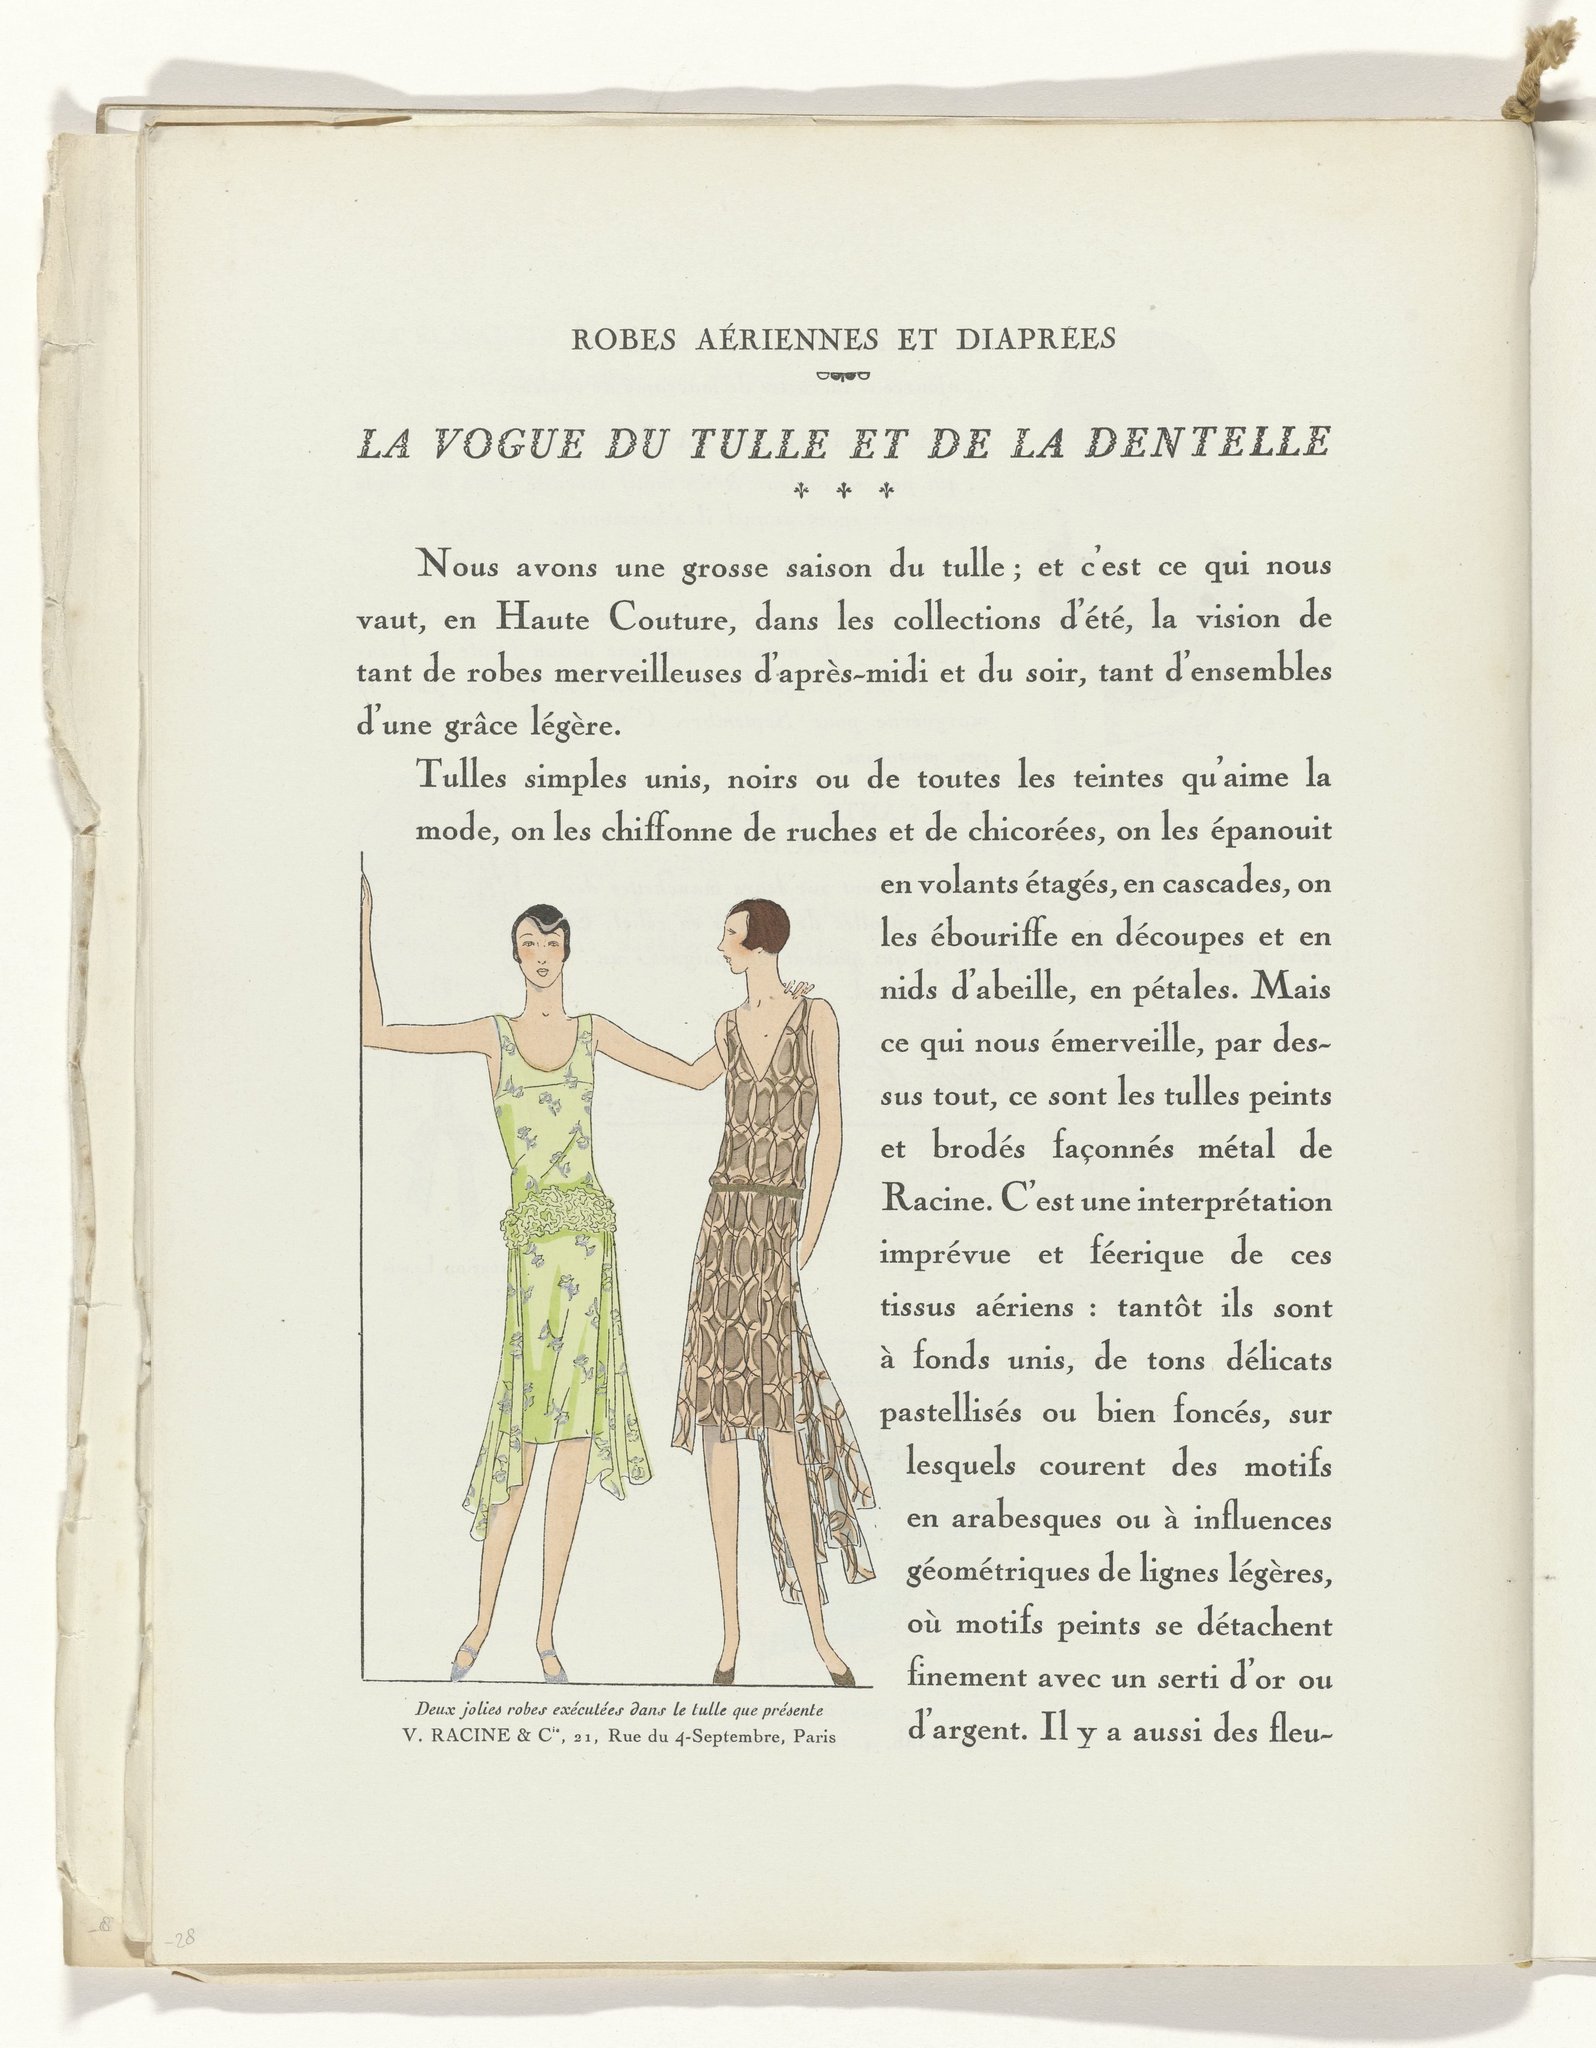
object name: magazine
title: Art - Goût - Beauté, Feuillets de l' élégance féminine, Mars 1929, No. 103, 9e Année, p. 28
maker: charles goy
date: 1929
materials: paint, paper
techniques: brush, hand coloring, lithograph, pochoir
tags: fashion plates, dress, gown (+ women's clothes)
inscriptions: caption: ‘Deux jolies robes exécutées dans le tulle que présente / V. RACINE & Cie, 21, Rue du 4 -Septembre, Paris’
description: "La Vogue de tulle et la dentelle": tekst met afbeeldingen van twee japonnen van beschilderde en geborduurde tule van V. Racine & Cie. Pagina uit het modetijdschrift Art-Goût-Beauté (1920-1933).